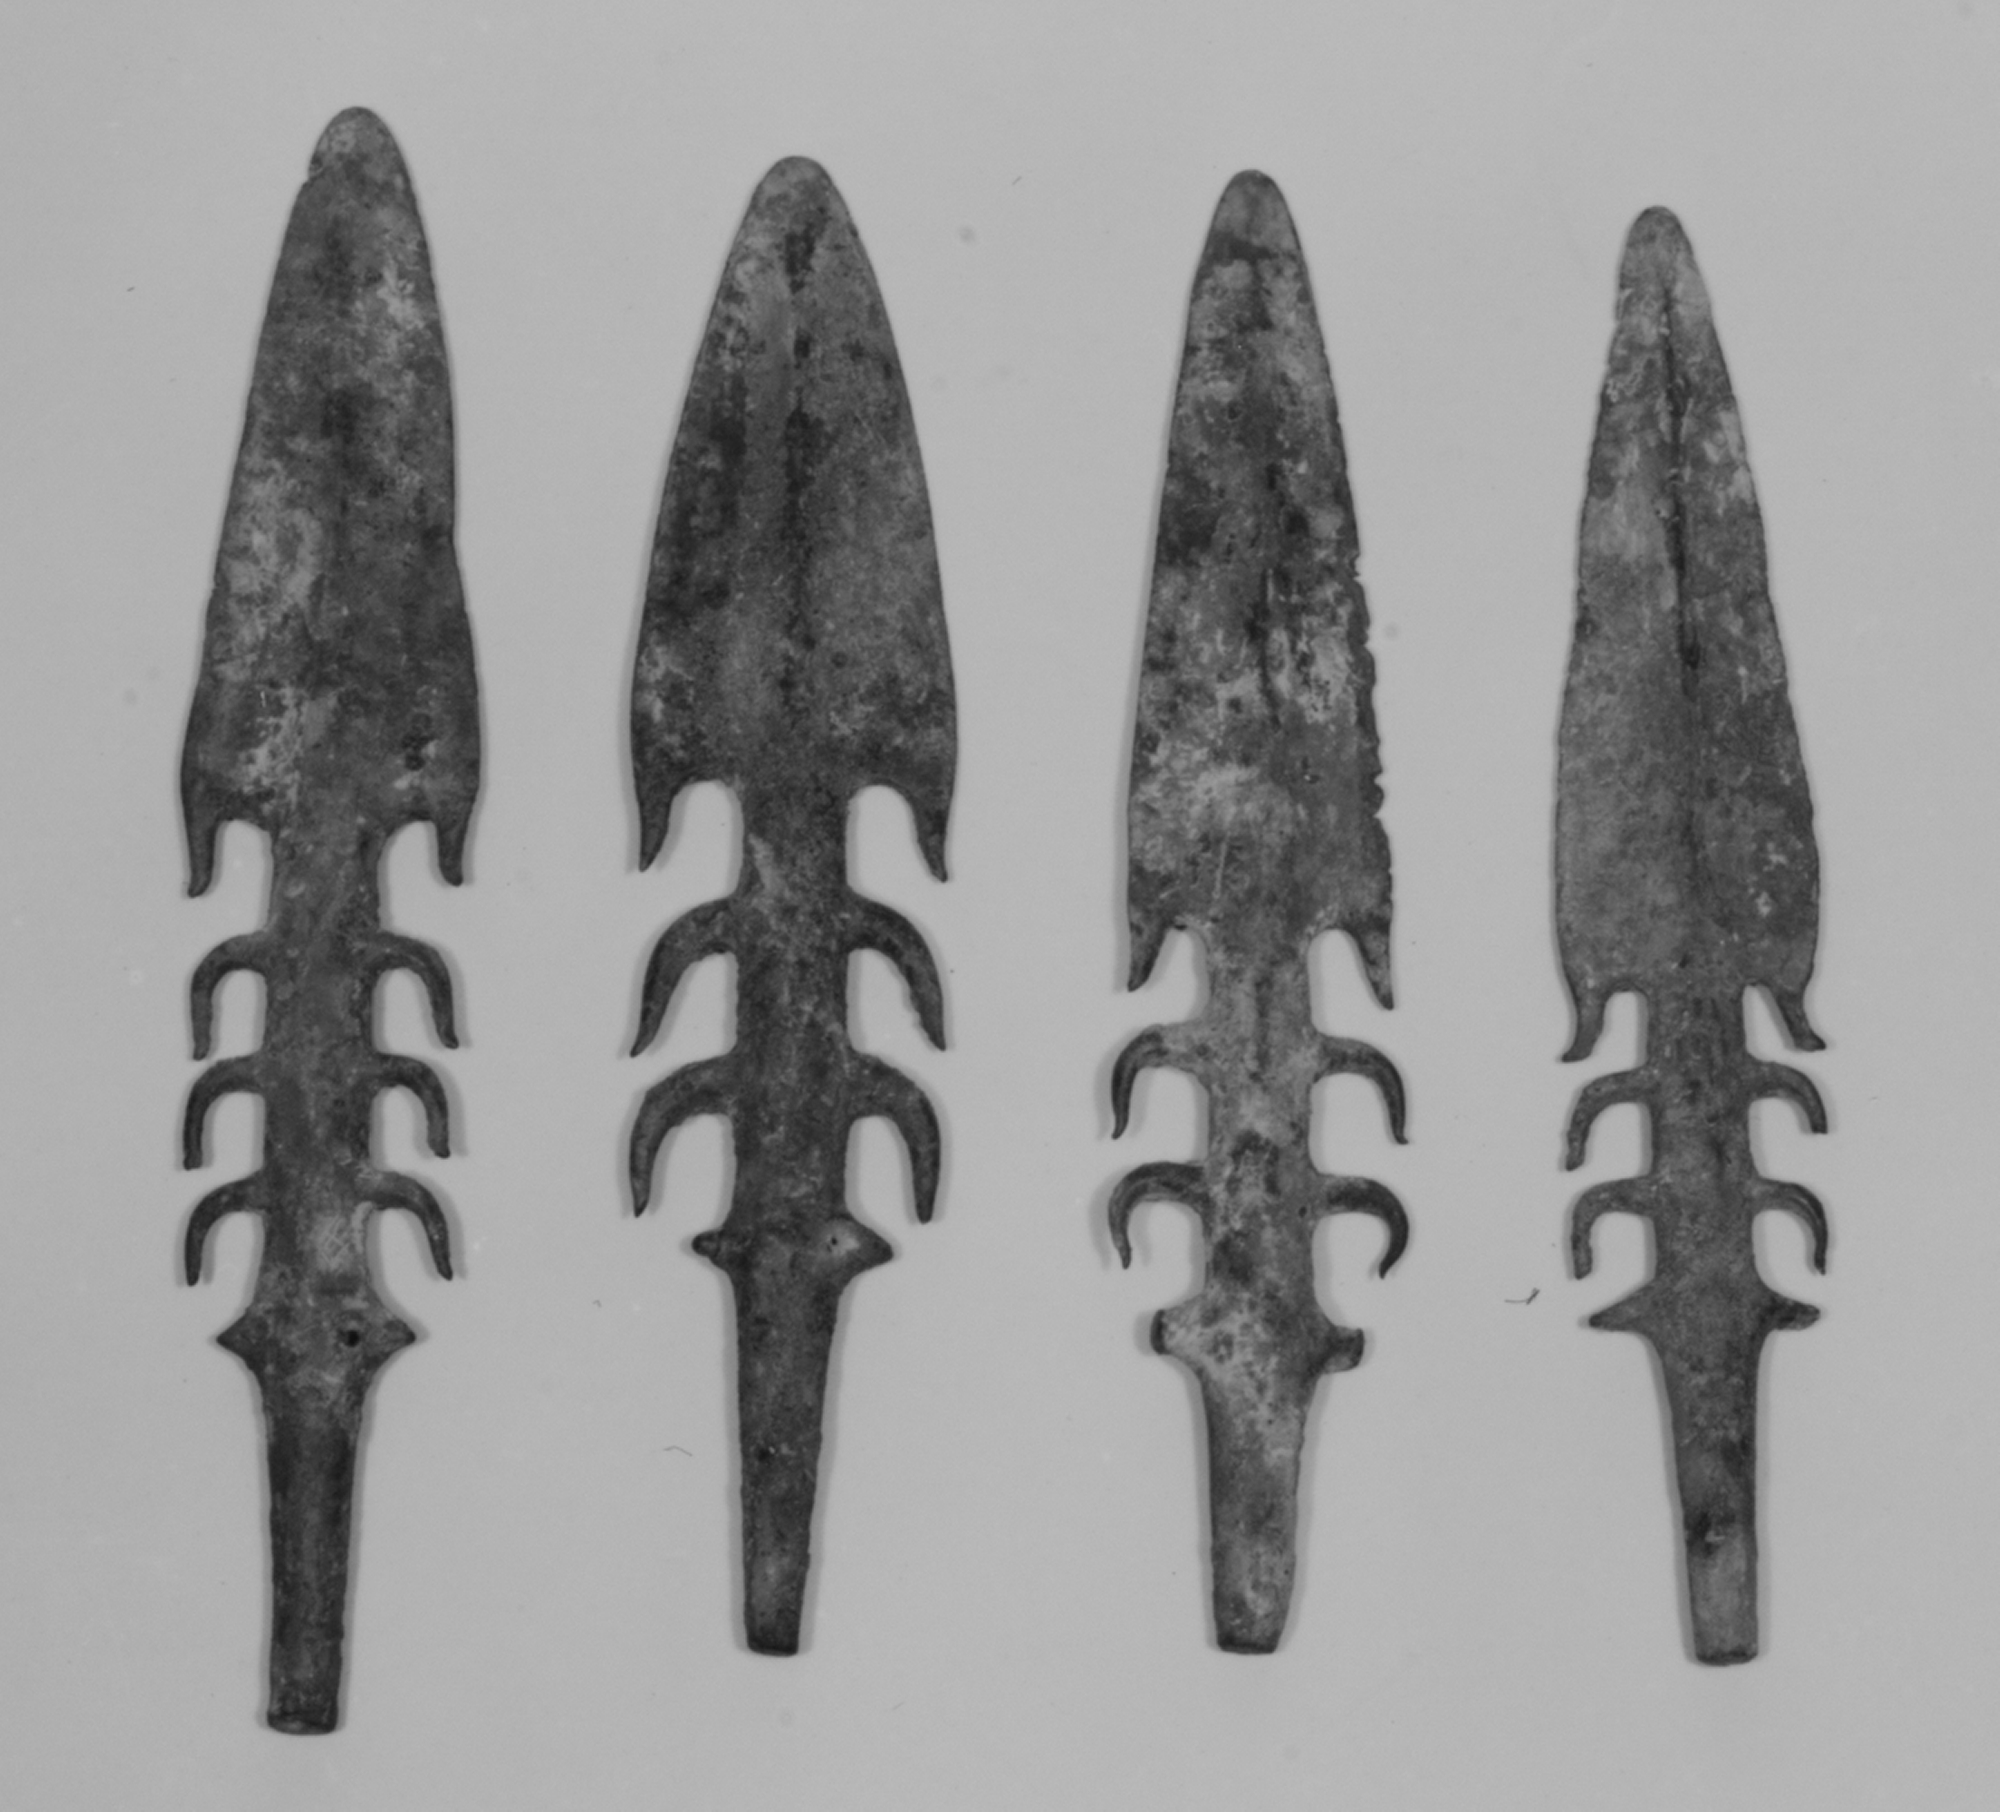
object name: harpoon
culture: indian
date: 1500-500 BCE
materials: copper